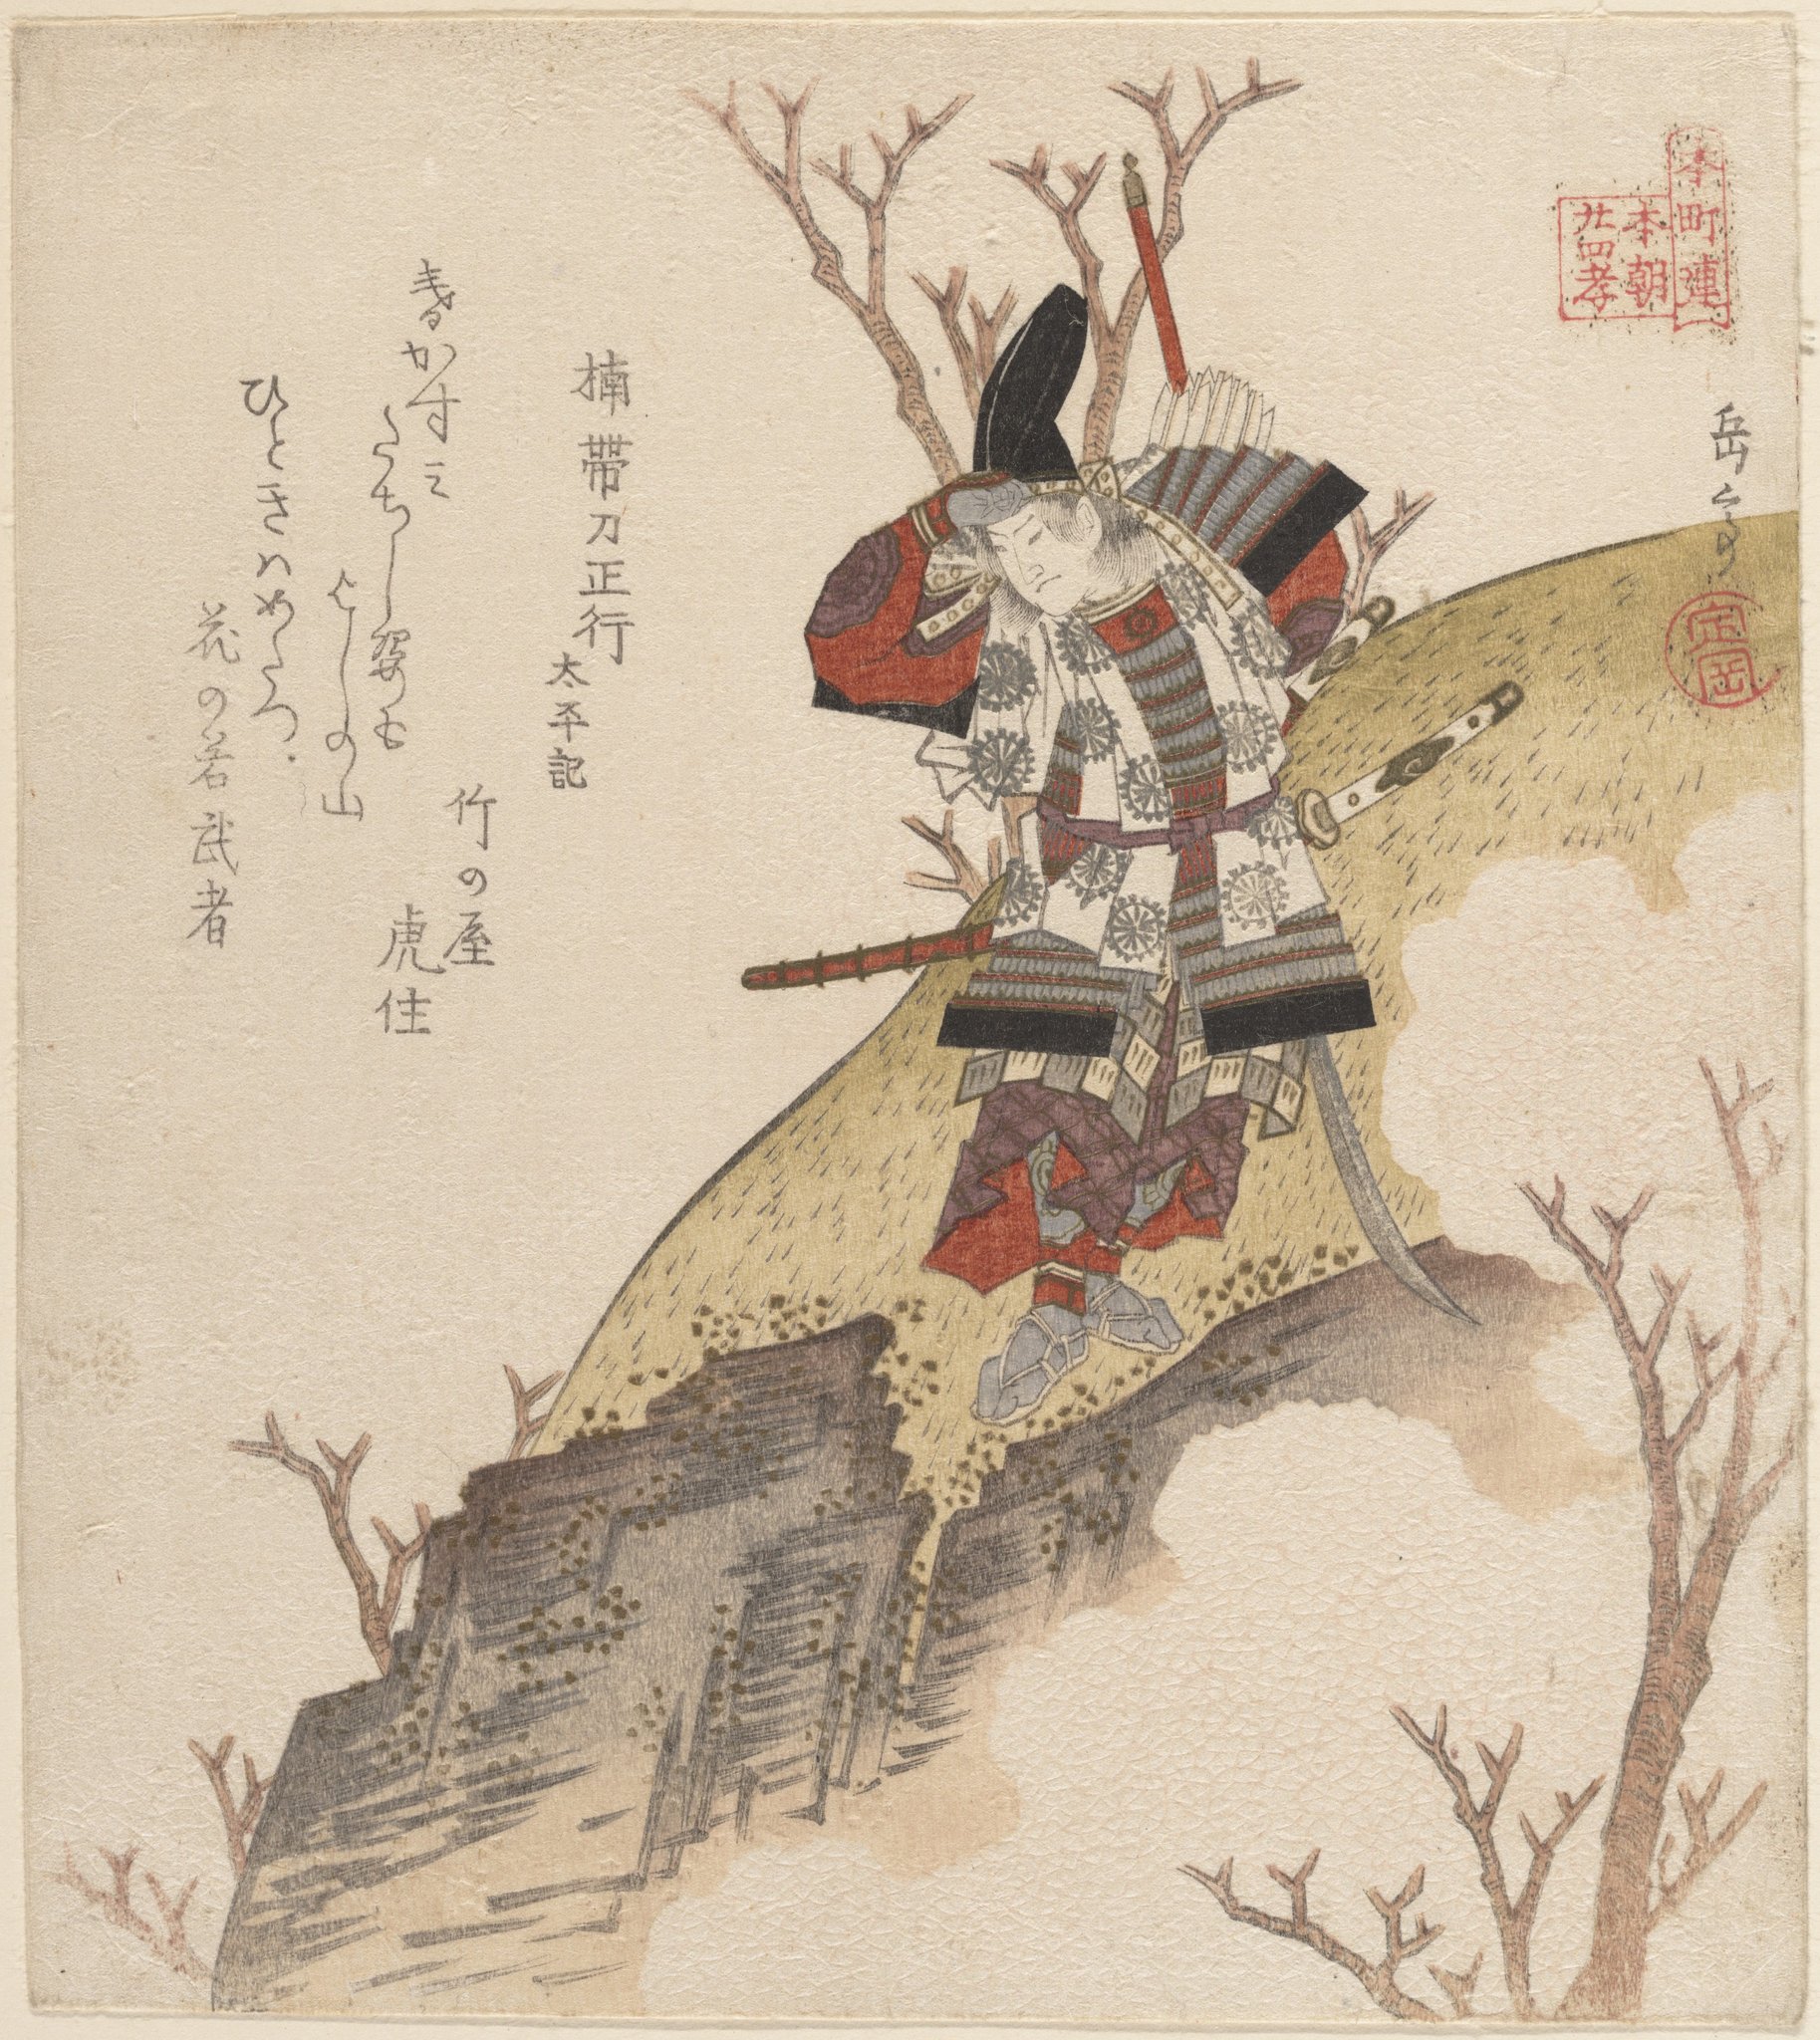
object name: woodblock print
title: Kusonoki Tatewaki Masatsura (Warrior From the Book: Taiheiki)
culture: japanese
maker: yashima gakutei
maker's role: artist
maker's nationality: japanese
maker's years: 1786-1868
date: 1840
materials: ink, paper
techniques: surimono, woodblock print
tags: swords,men